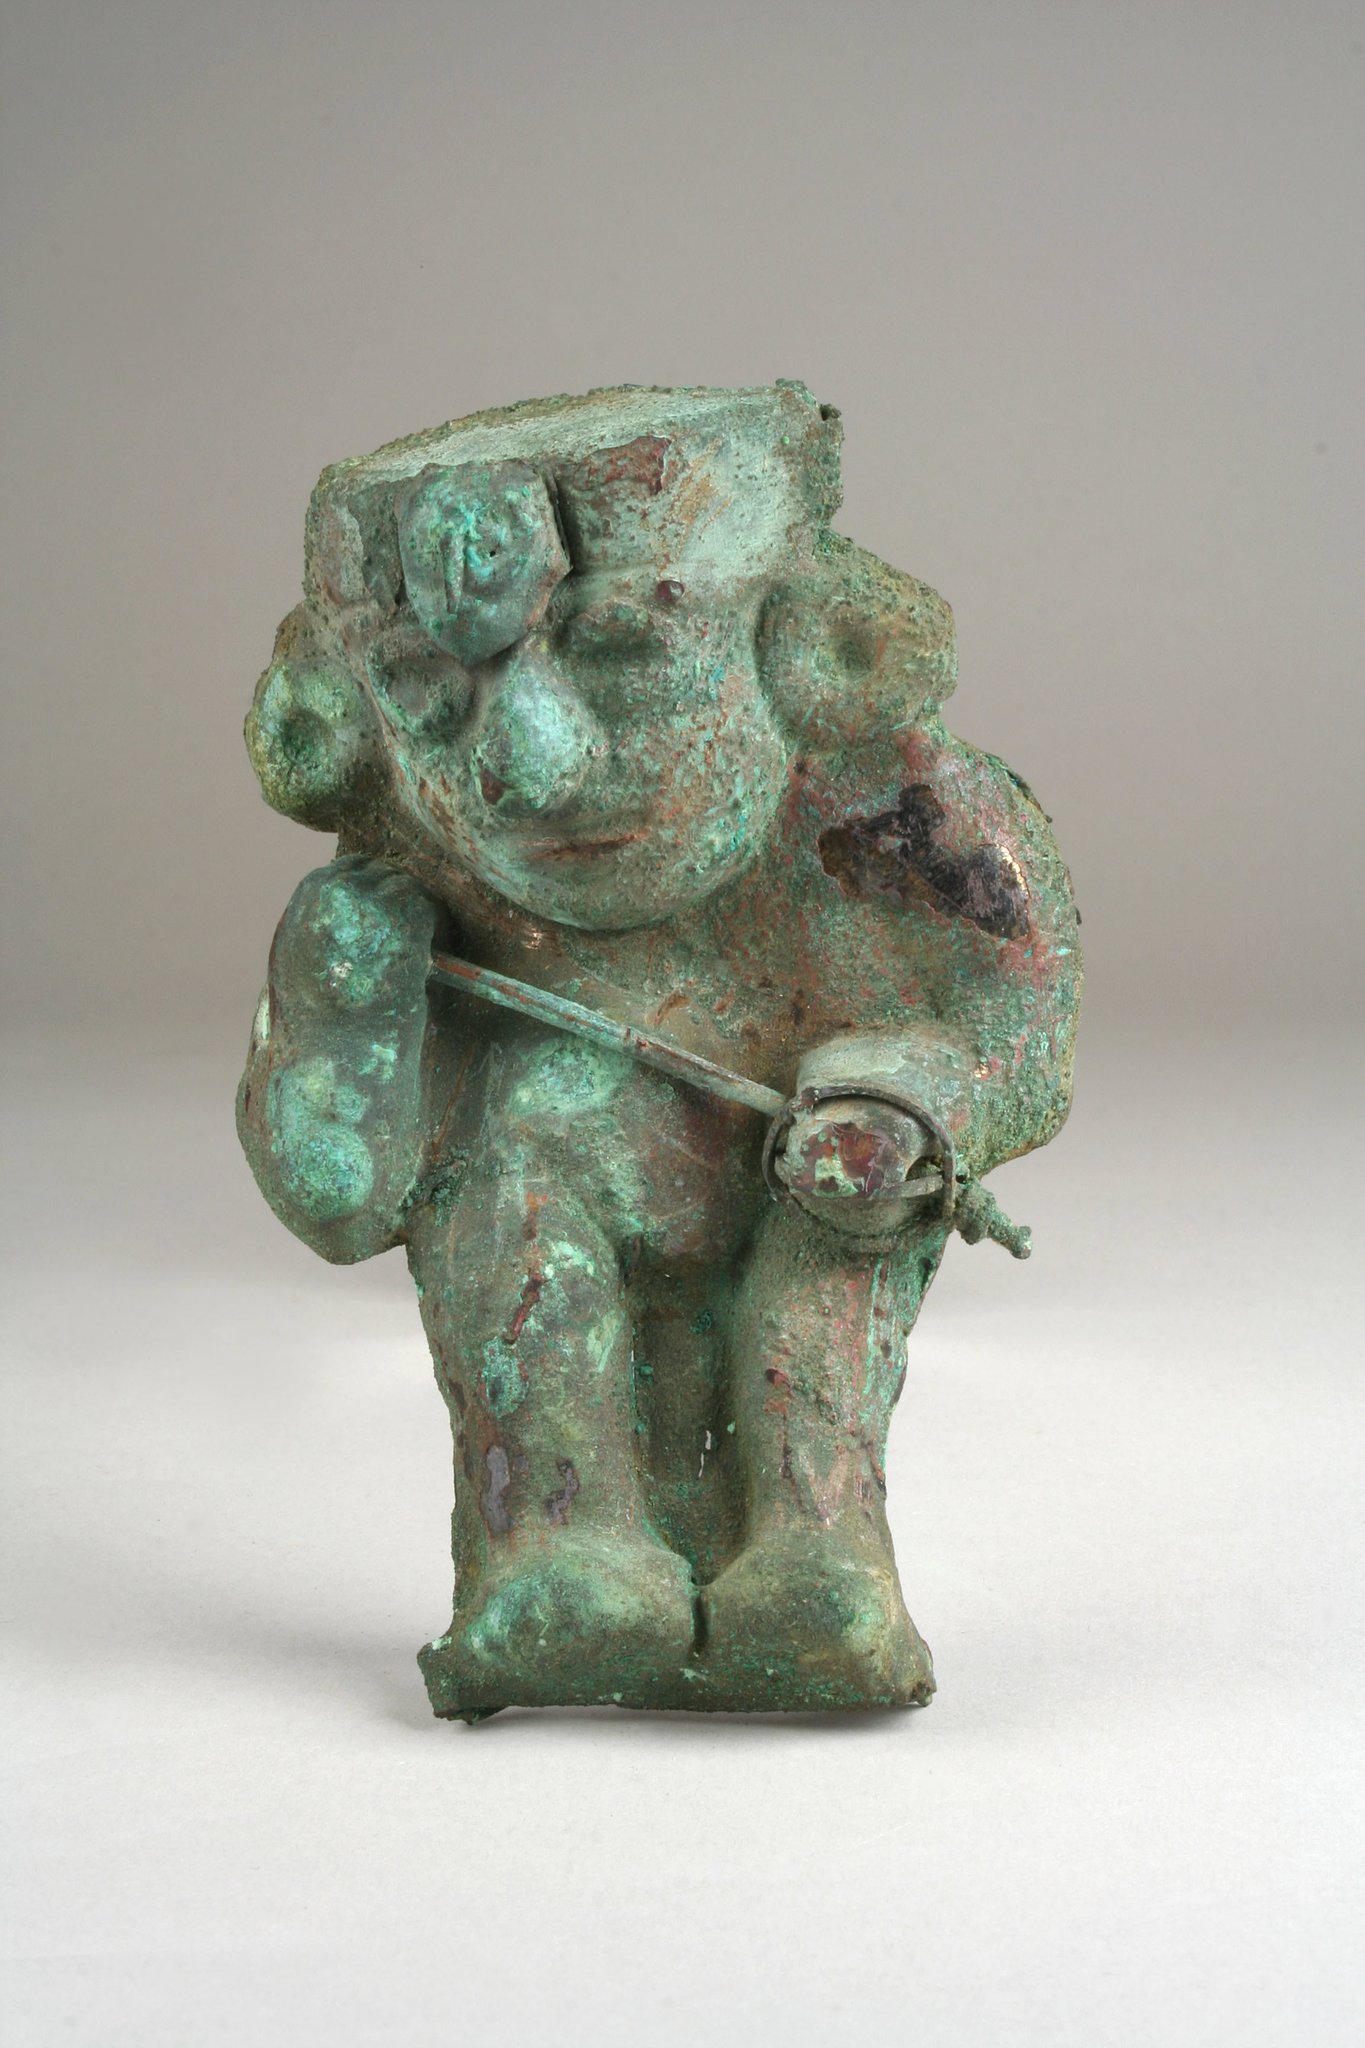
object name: ornament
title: Warrior Figure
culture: moche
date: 501-700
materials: metal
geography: peru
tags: warriors